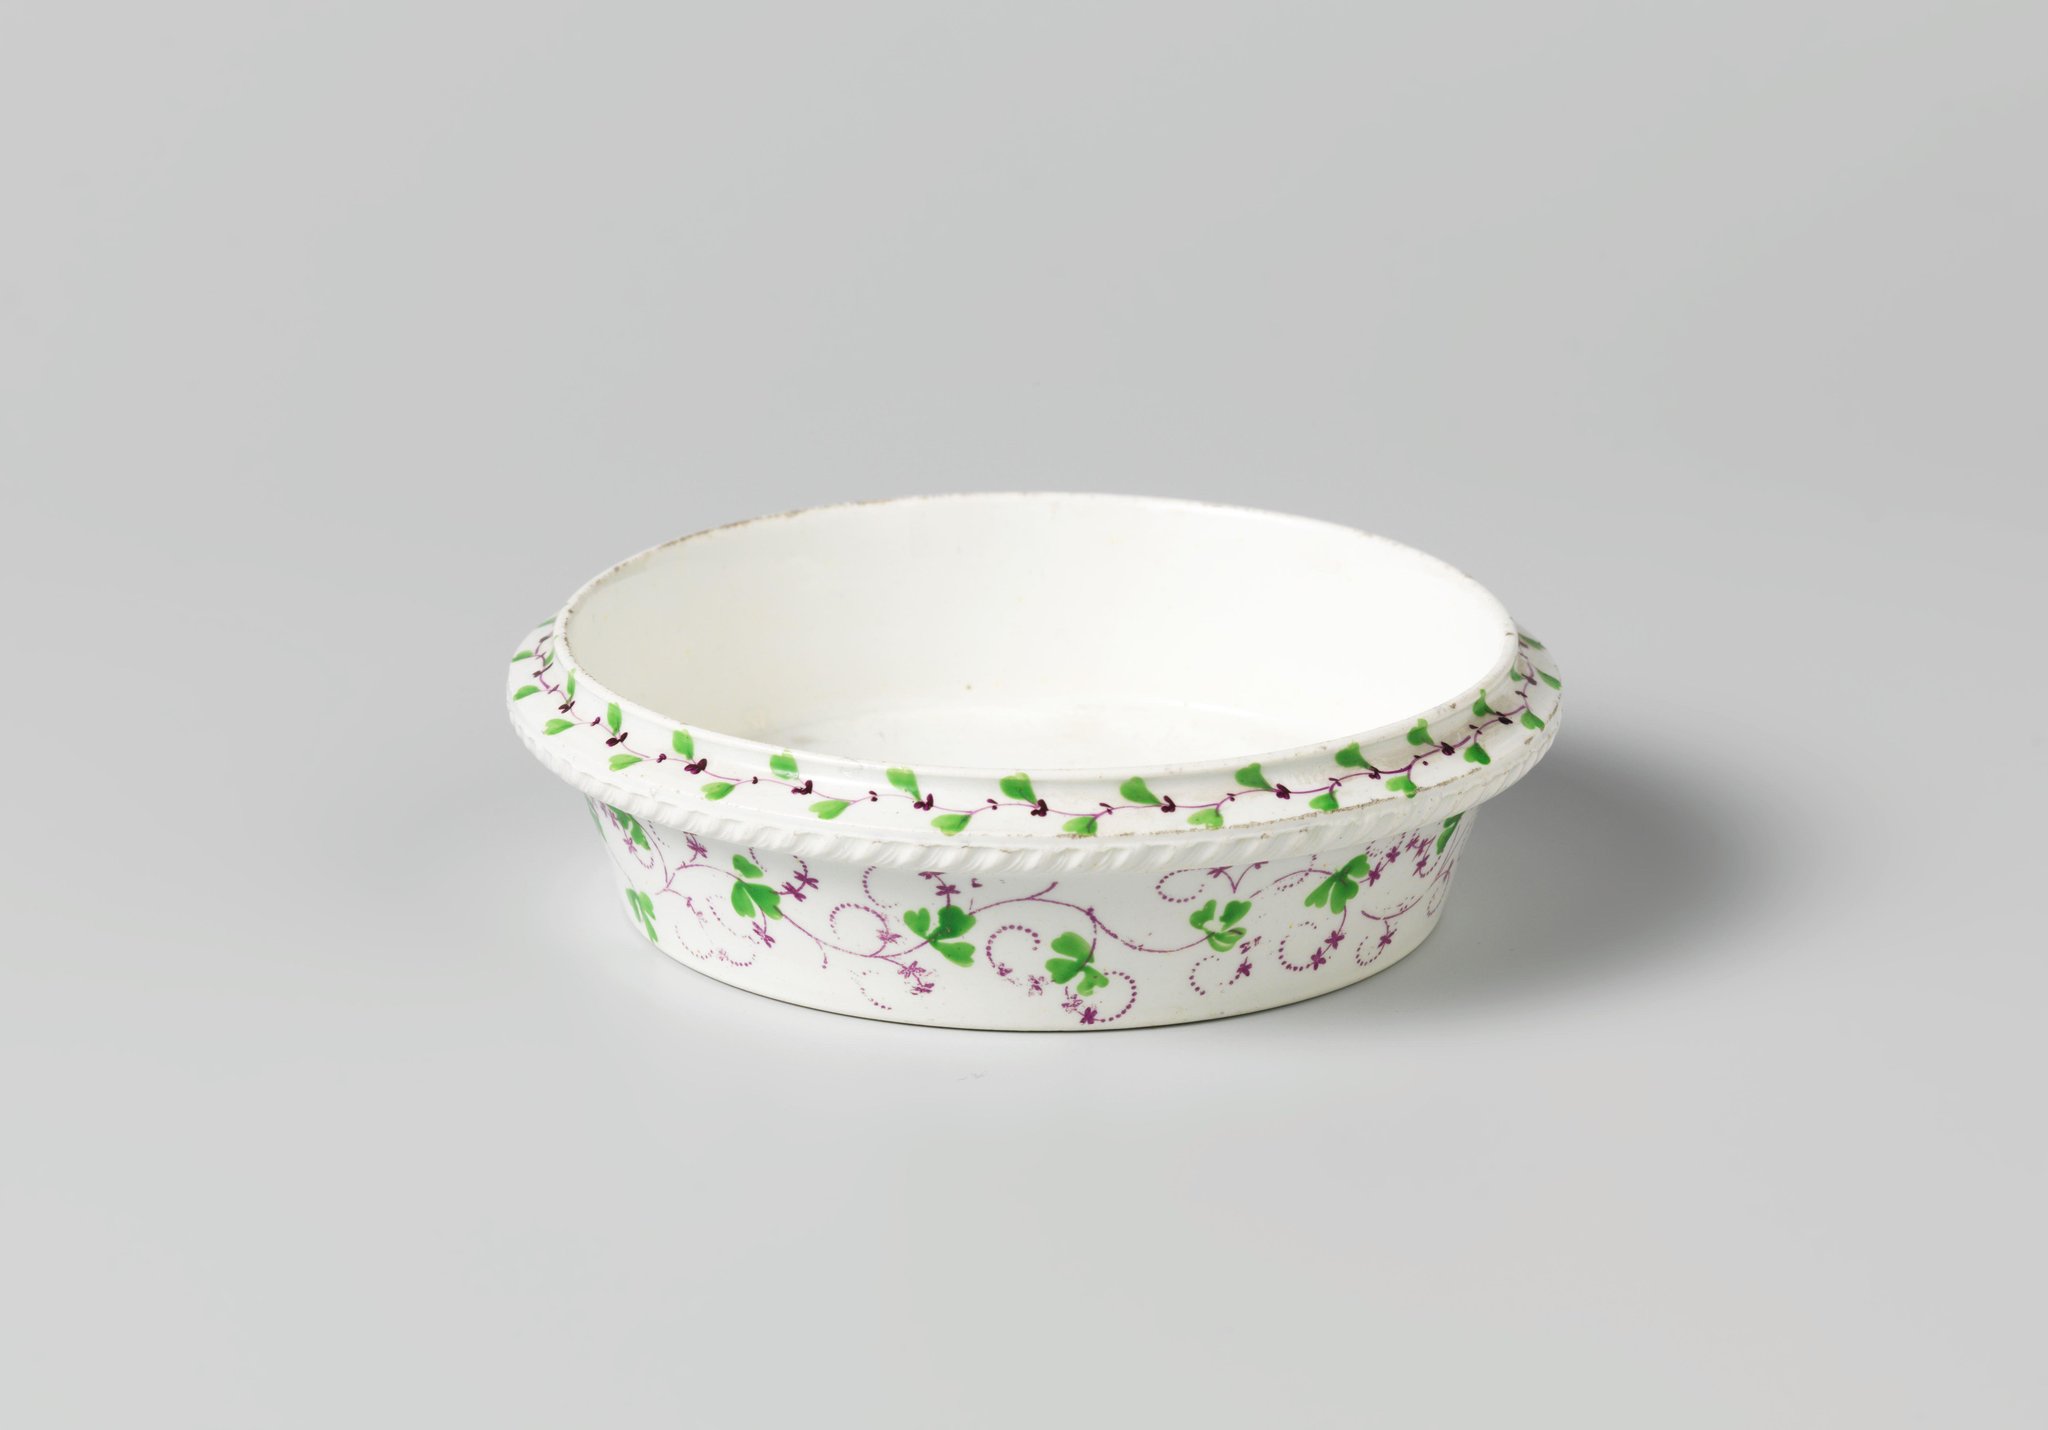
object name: platter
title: Schotel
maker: Anonymous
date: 1770-1810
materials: earthenware, glaze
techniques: painted, polychromy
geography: france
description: Ronde schotel met opstaande rand van veelkleurig beschilderde faiences fines. De schotel is beschilderd met paarse, dunne takken met groene bladeren. Onder de rand is de wand verdikt en geribd. De schotel hoort met drie andere schotels (BK-NM-14097-a, BK-NM-14097-c en BK-NM-14097-d) bij twee bloempotten (BK-NM-14097-e en BK-NM-14097-f).